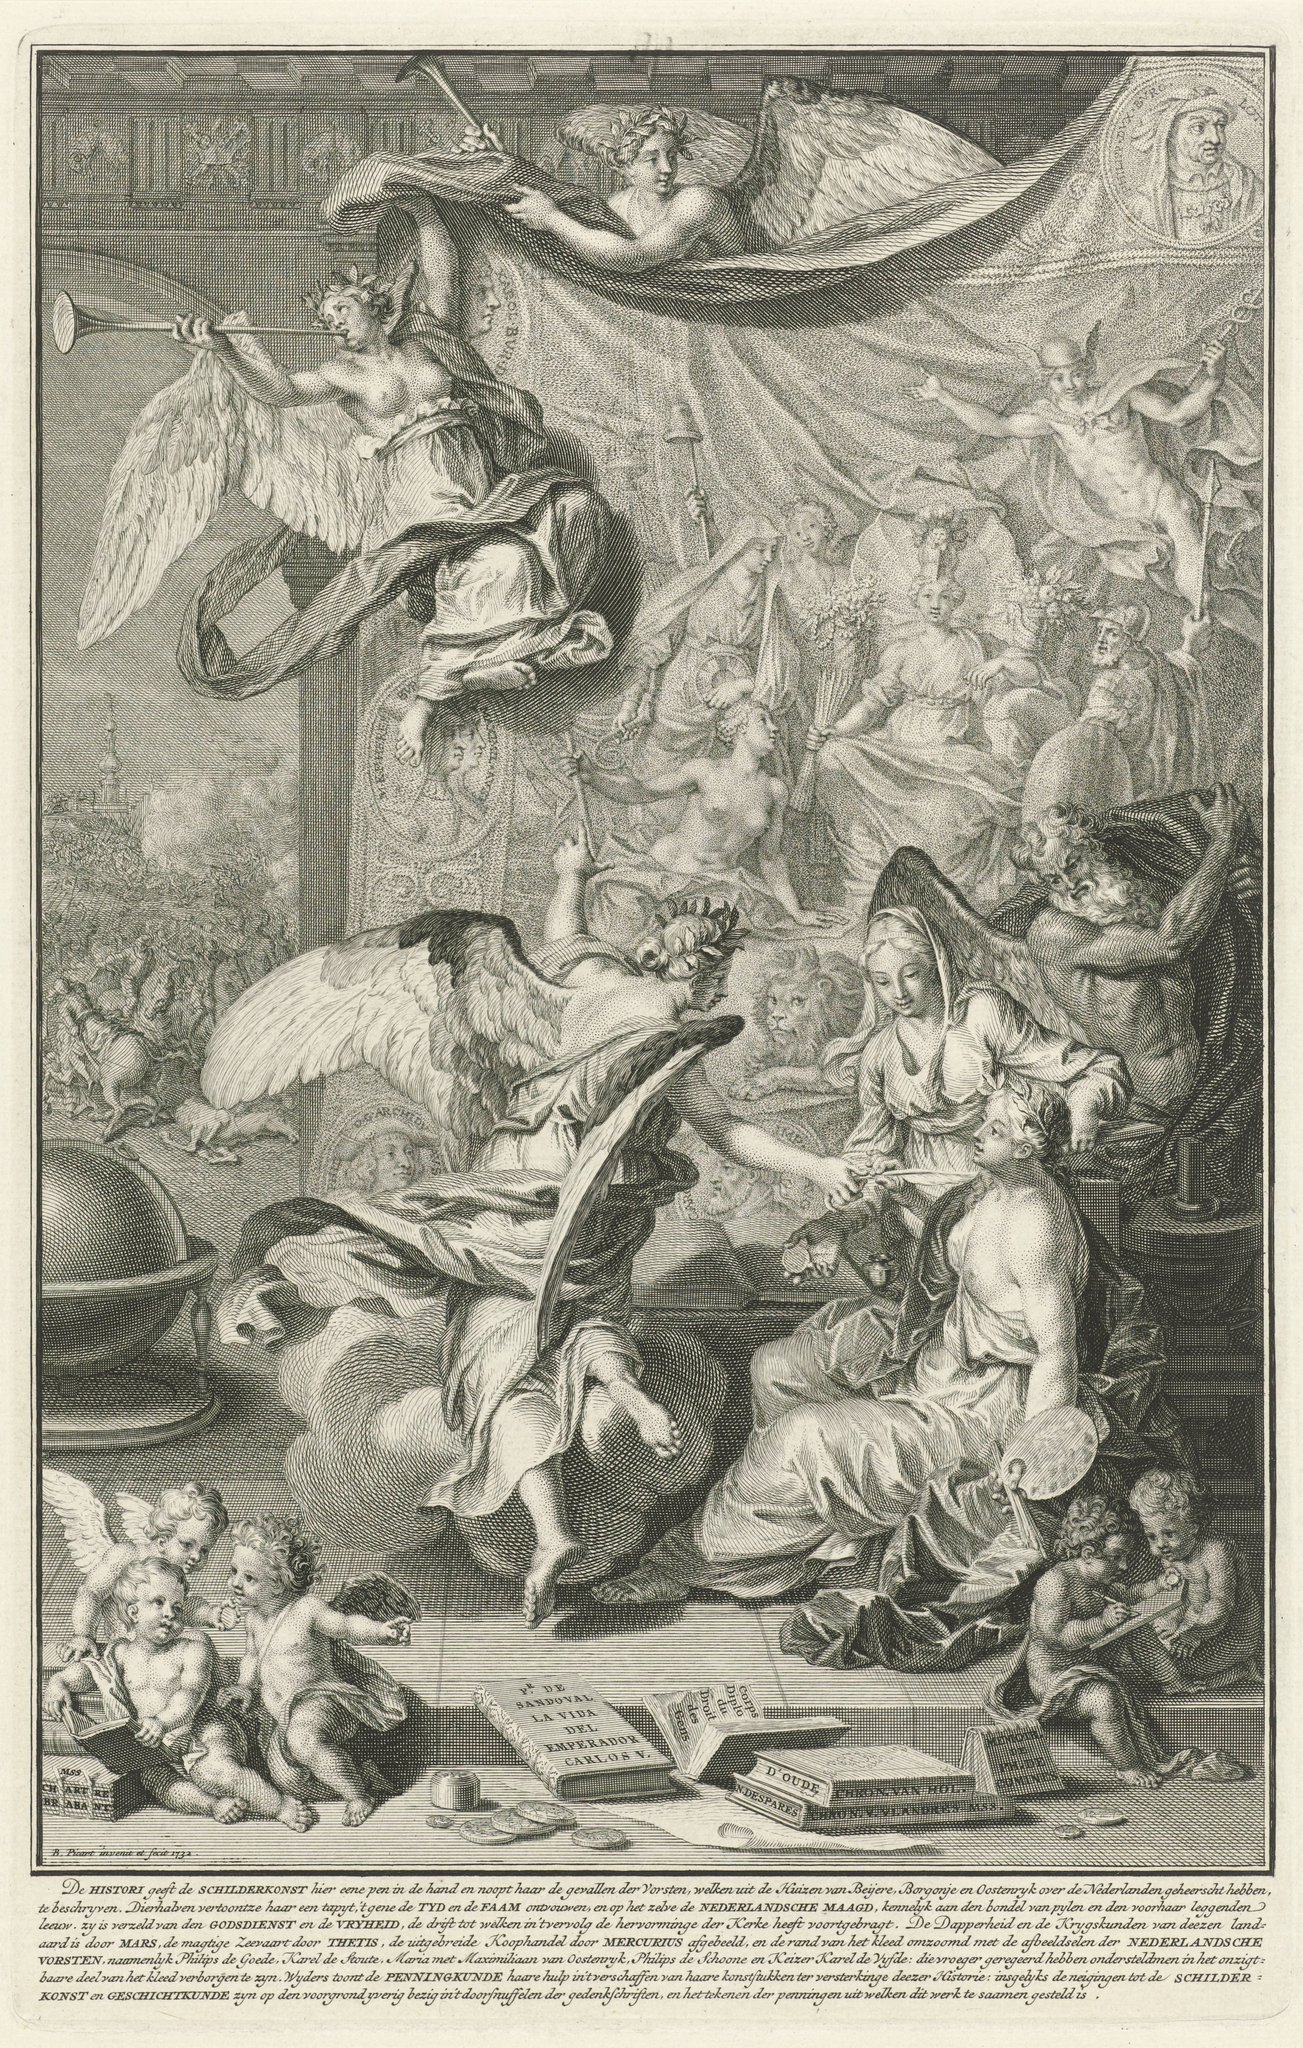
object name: print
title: Geschiedenis geeft de Schilderkunst een schrijfveer om de geschiedenissen van de Nederlandse vorsten op te tekenen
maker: bernard picart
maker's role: draughtsman, print maker, publisher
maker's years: 1673-1733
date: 1732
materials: paper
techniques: engraving, etching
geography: amsterdam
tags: ghent, charles v (holy roman emperor and king of spain), (story of) mars (ares), faith, 'fides'; 'fede', 'fede catholica', 'fede christiana', 'fede christiana catholica' (ripa) ~ one of the three theological virtues, 'pictura', symbolic representations, allegories and emblems ~ painting; 'pittura' (ripa), personifications of countries, nations, states, districts, etc., (story of) thetis; 'thethi, ninfa del mare' (ripa), 'historia'; 'historia' (ripa), fame; 'fama', 'fama buona', 'fama chiara' (ripa), freedom, liberty; 'libertà' (ripa), father time, man with wings and scythe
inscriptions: collector's mark: Lugt 2228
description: Allegorische voorstelling waarin Geschiedenis de Schilderkunst een schrijfveer in de hand geeft om de geschiedenissen van de Nederlandse vorsten op te tekenen. Ze wijst op een tapijt waarop de Nederlandse Maagd, vergezeld door Vrijheid, Geloof, Thetis, Mars en Mercurius en langs de randen medaillons waarin de portretten van Nederlandse vorsten. Links op de achtergrond een veldslag. Met een zevenregelig onderschrift in het Nederlands.